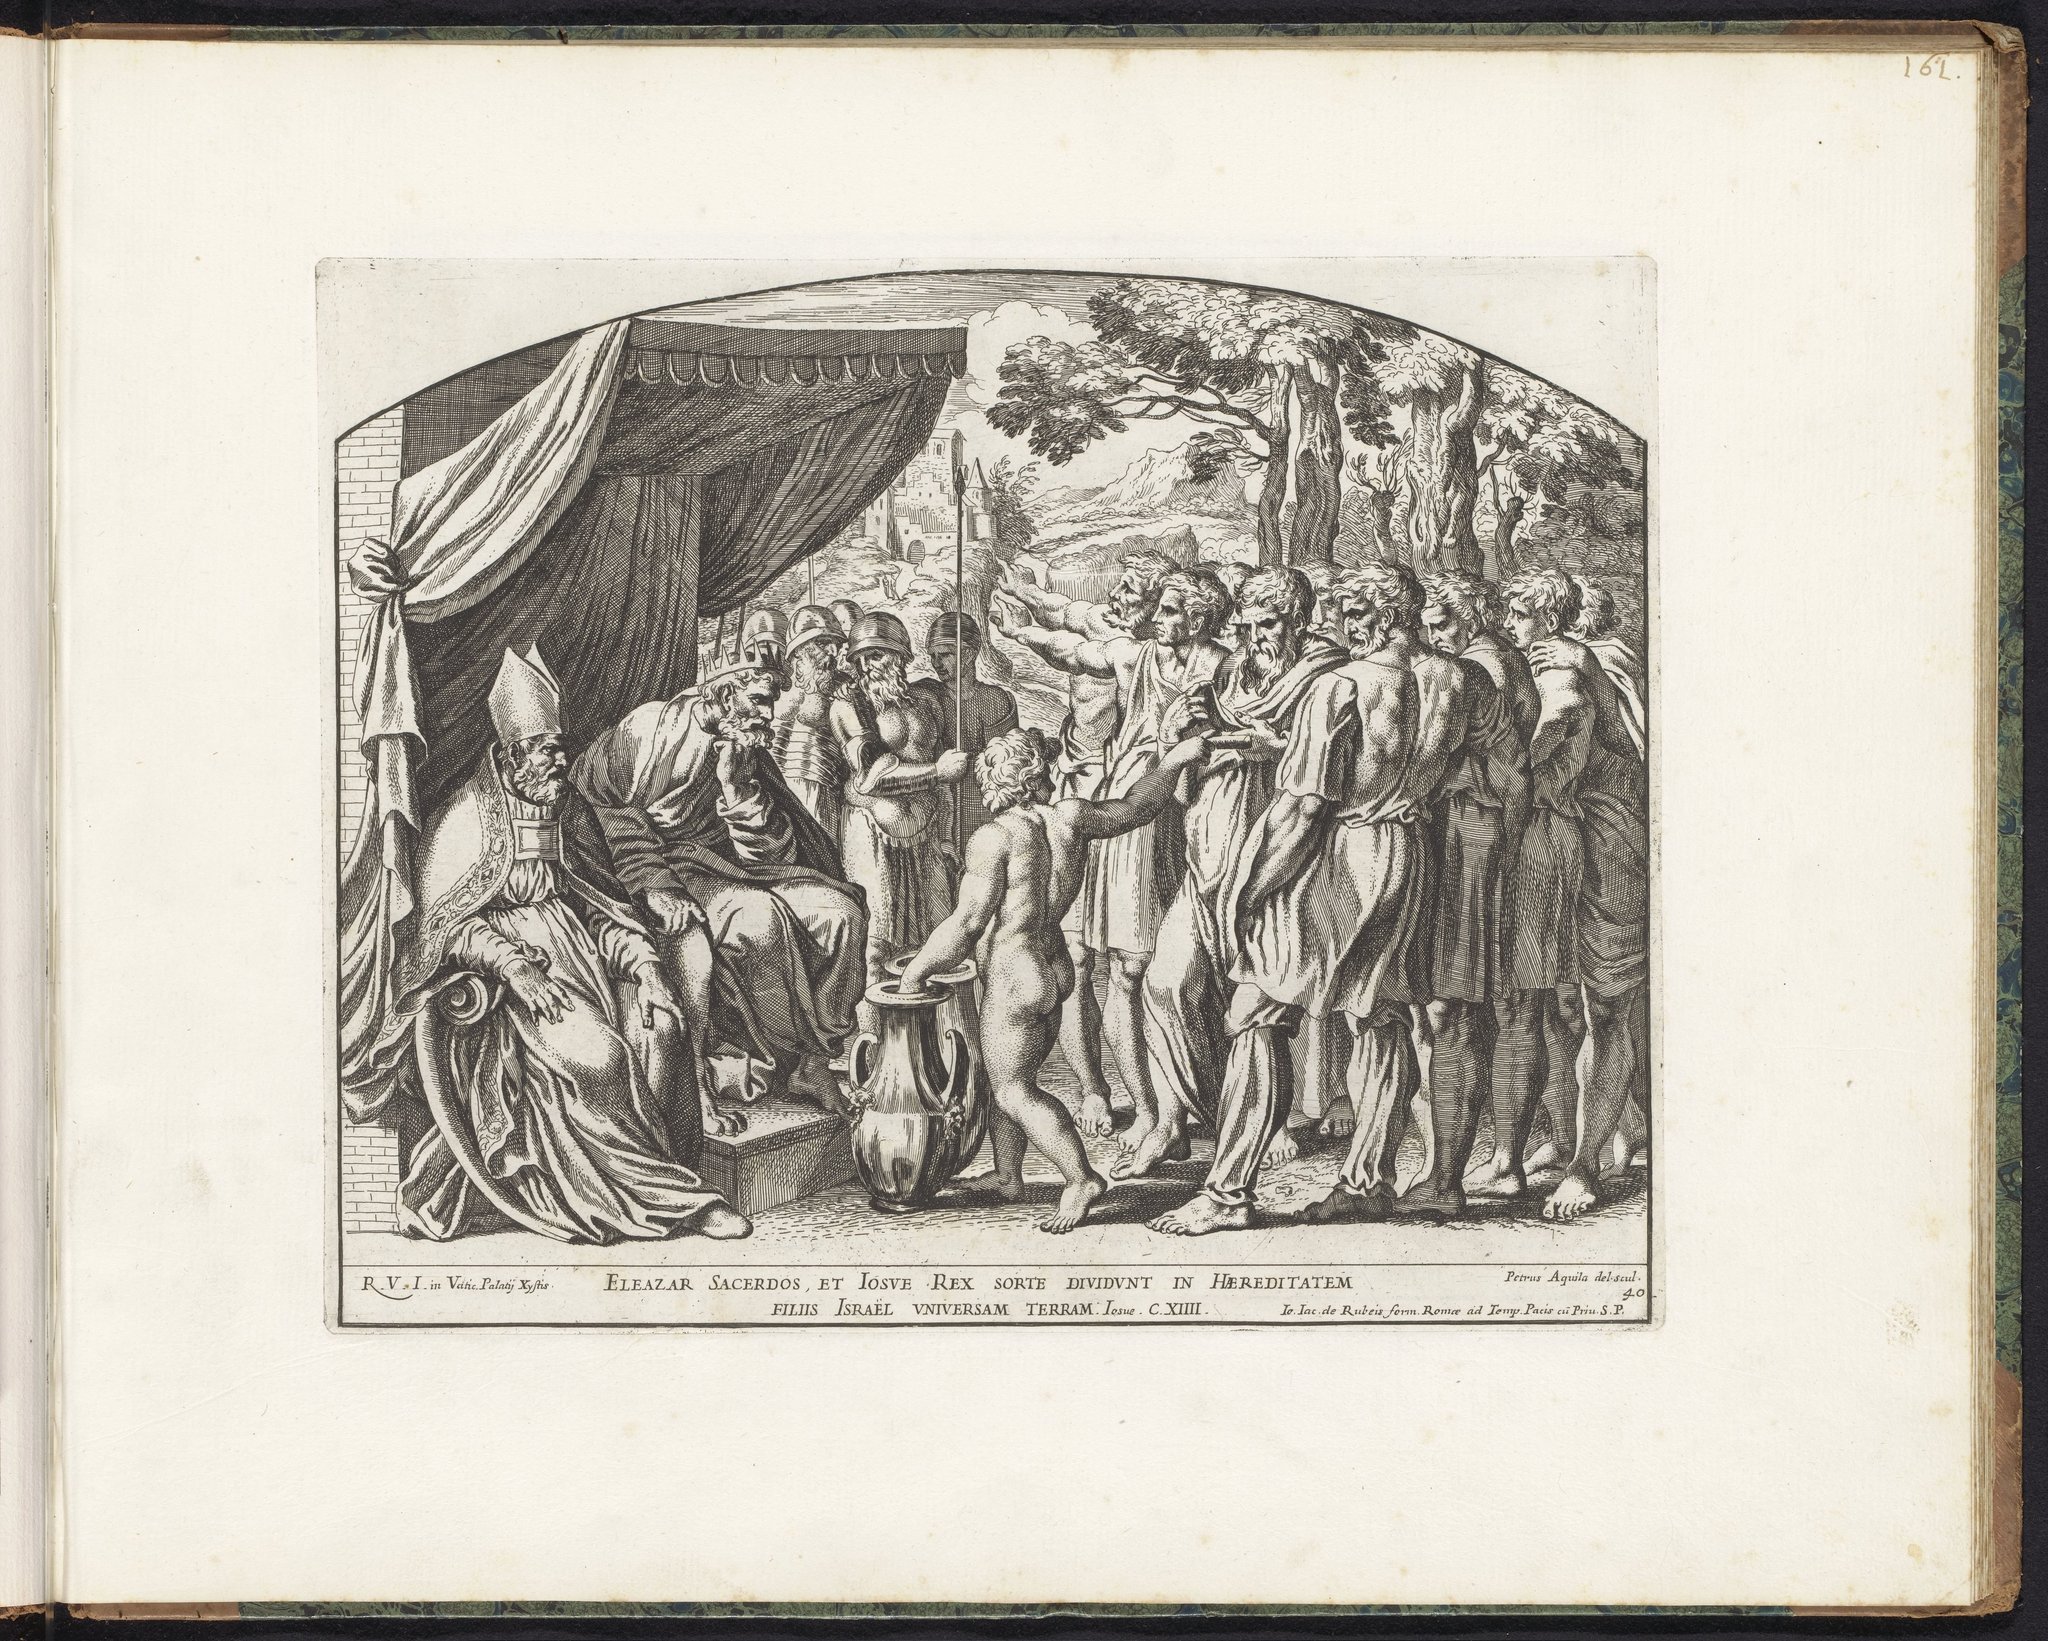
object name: album leaf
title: Schilderingen in de Loggia van Rafaël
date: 1675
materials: paper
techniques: etching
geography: vatican city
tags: by drawing lots, joshua, eleazar and the leaders of the tribes of israel assign cities to the levites (joshua 21)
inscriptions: number: ‘161’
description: Eleazar en Jozua zitten onder een baldakijn. Voor hen staan de aanvoerders van de twaalf stammen van Israël. Ze bespreken de verdeling van het Beloofde Land. Op de voorgrond staat een naakt jongetje bij een kruik. Bijbelvers onder de voorstelling. Prent maakt deel uit van een album.